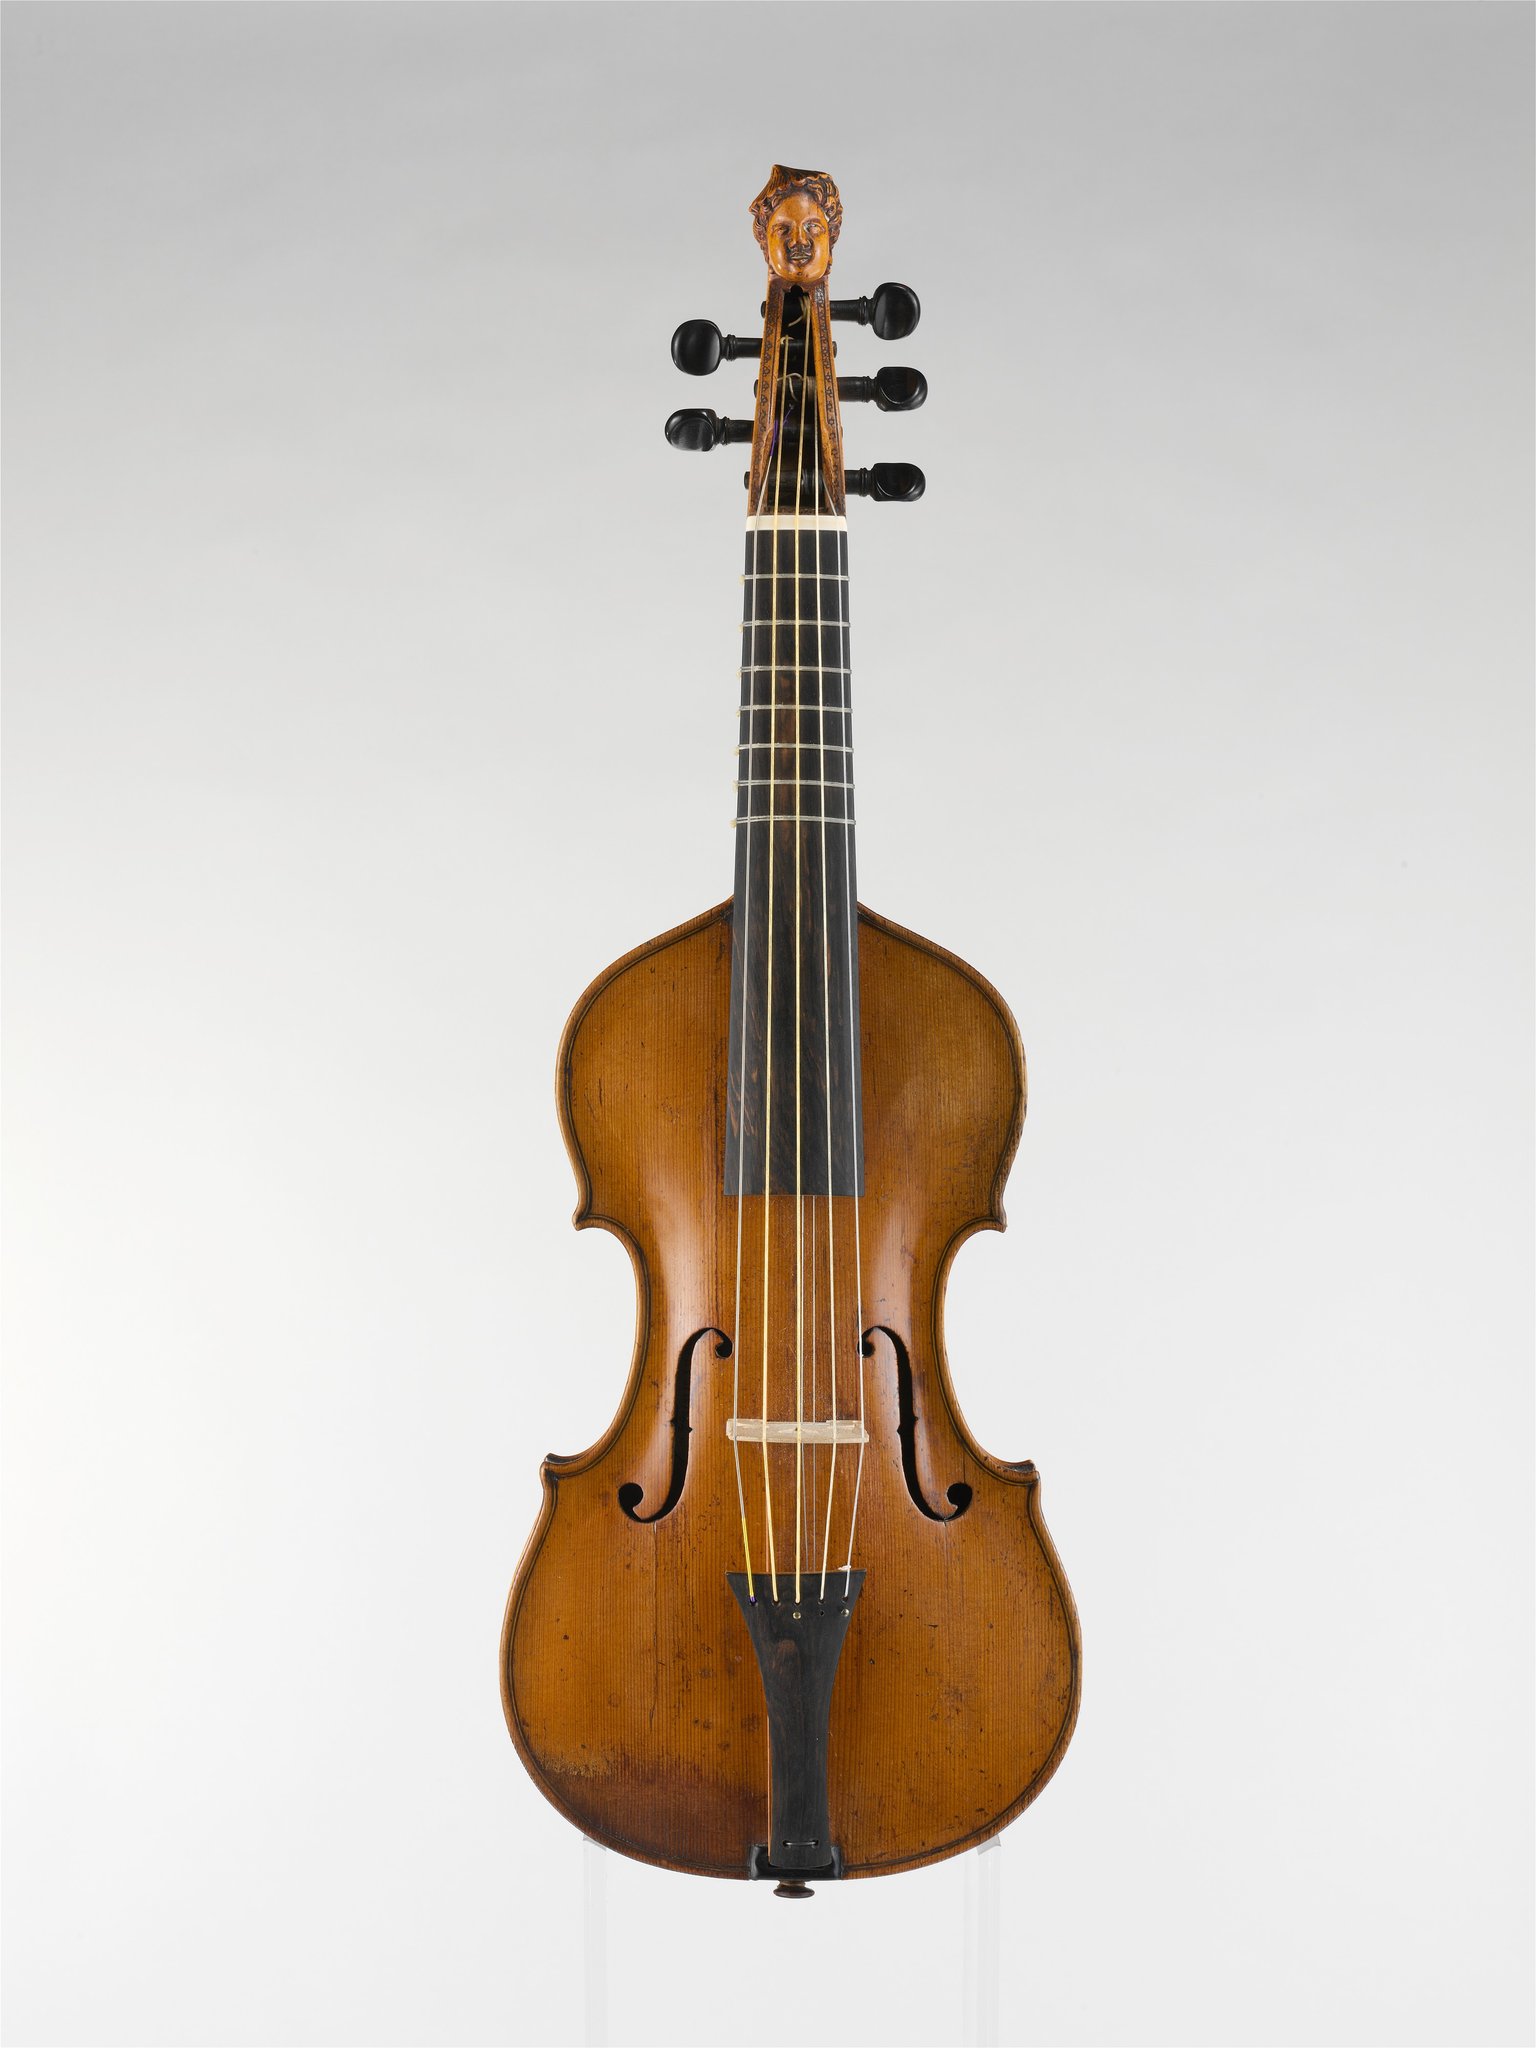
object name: quinton d'amore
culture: french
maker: mathurin-françois remy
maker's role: maker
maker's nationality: french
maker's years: 1725-1825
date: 1755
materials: wood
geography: france